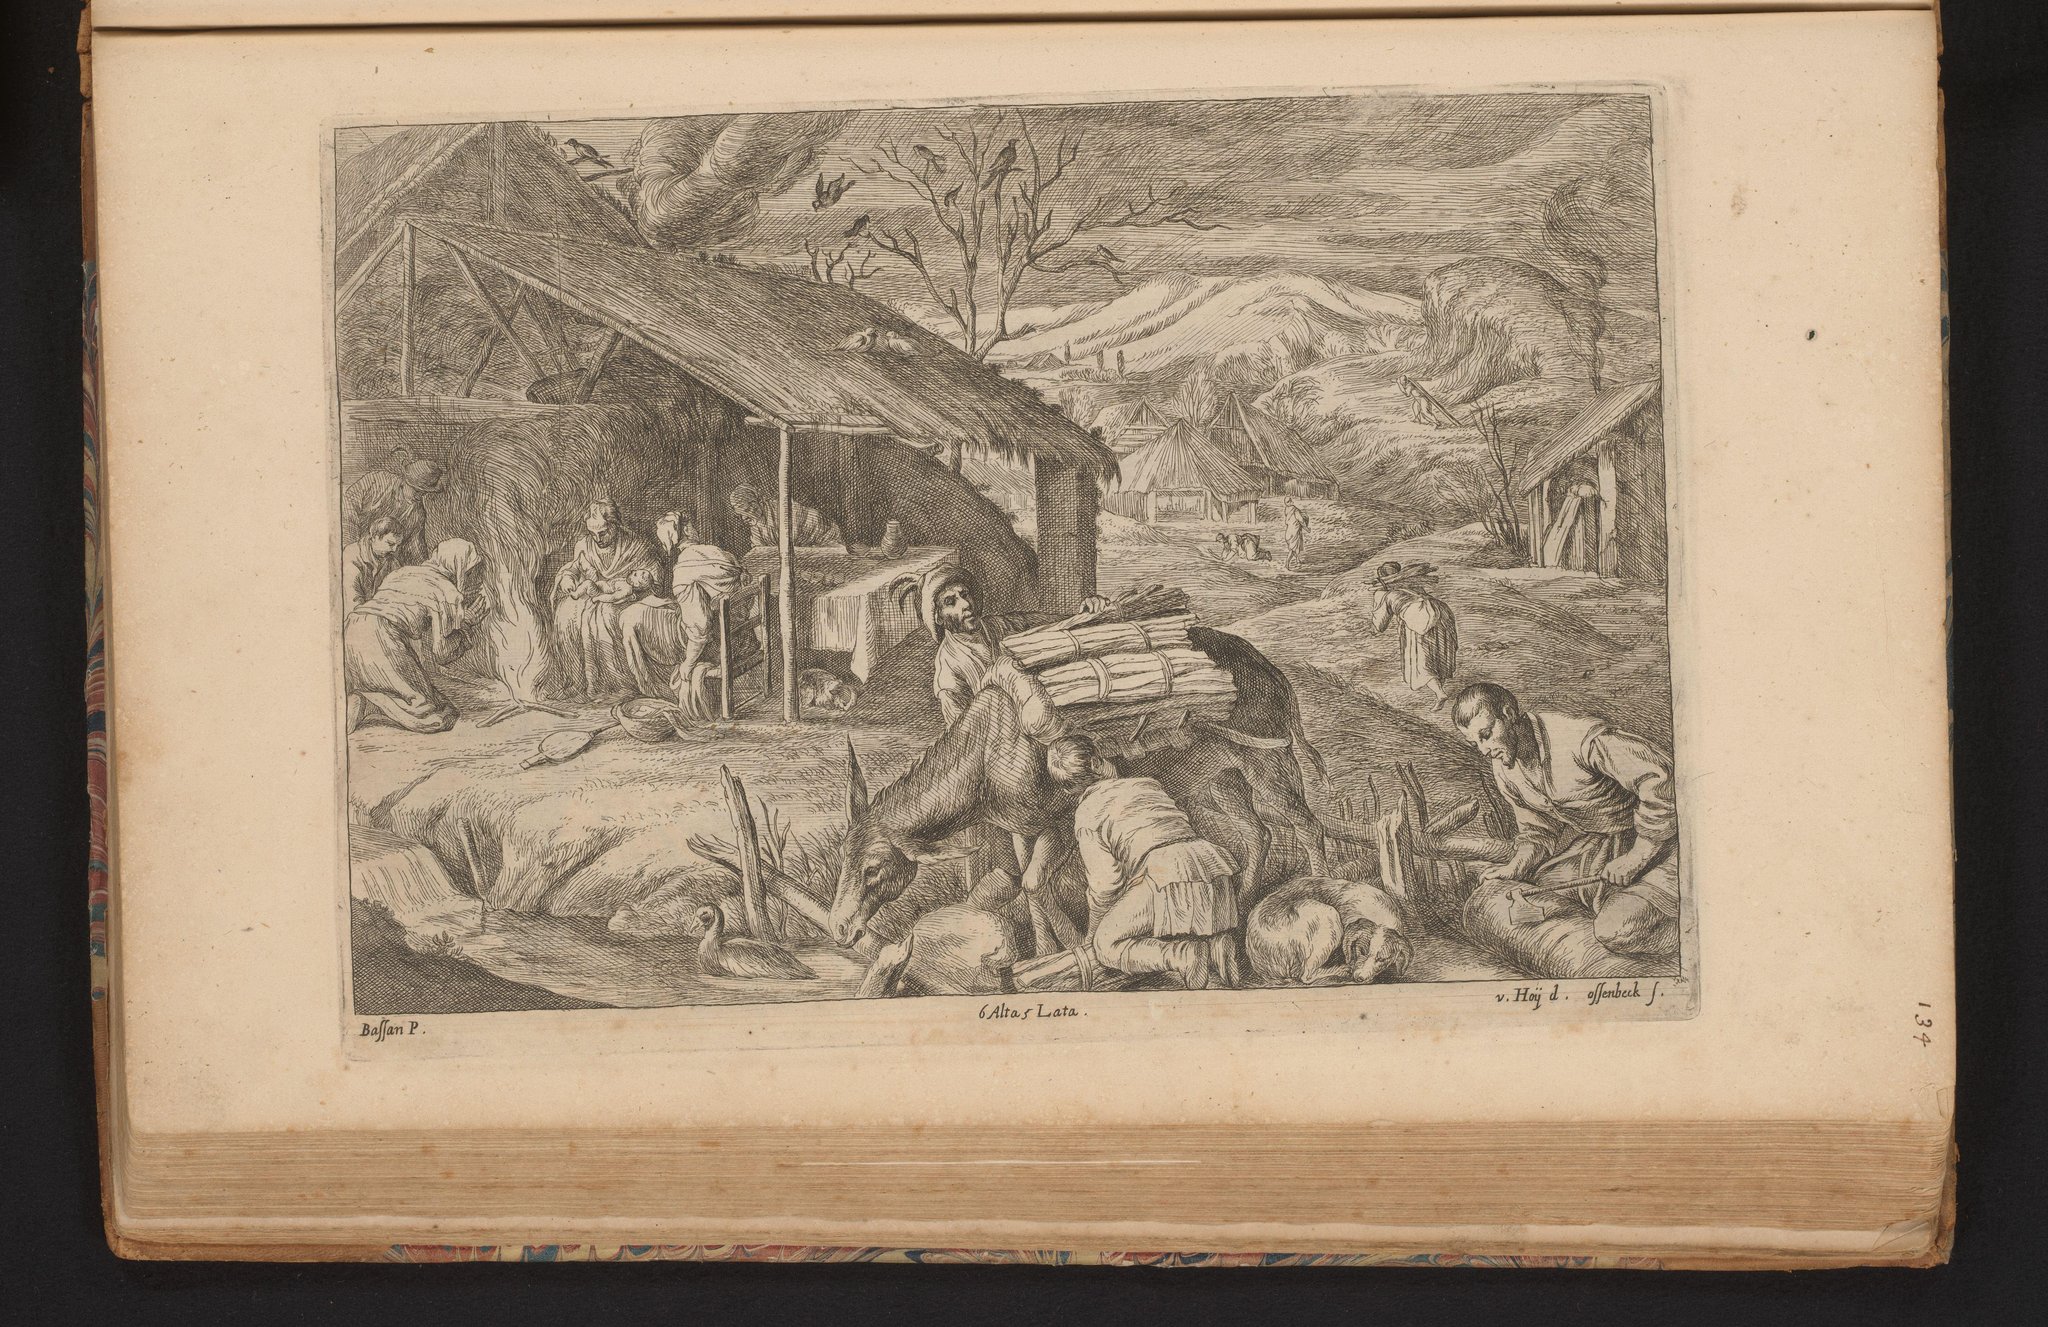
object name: print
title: De vier seizoenen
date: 1660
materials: paper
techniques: etching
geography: brussels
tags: woodcutting, woodcutter ~ forestry, winter ~ human activities (the four seasons of the year) (+ with scenes showing human occupations ~ seasons and months), bonfire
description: David Teniers heeft waarschijnlijk van alle schilderijen uit de collectie van Leopold Willem van Oostenrijk een olieverfstudie op doek of paneel vervaardigd (zgn. pasticcio), die als voorbeeld voor de prentmakers diende. Het is niet altijd duidelijk of de pasticci door hem zijn gemaakt of door zijn atelier. Niet alle pasticci zijn overgeleverd.